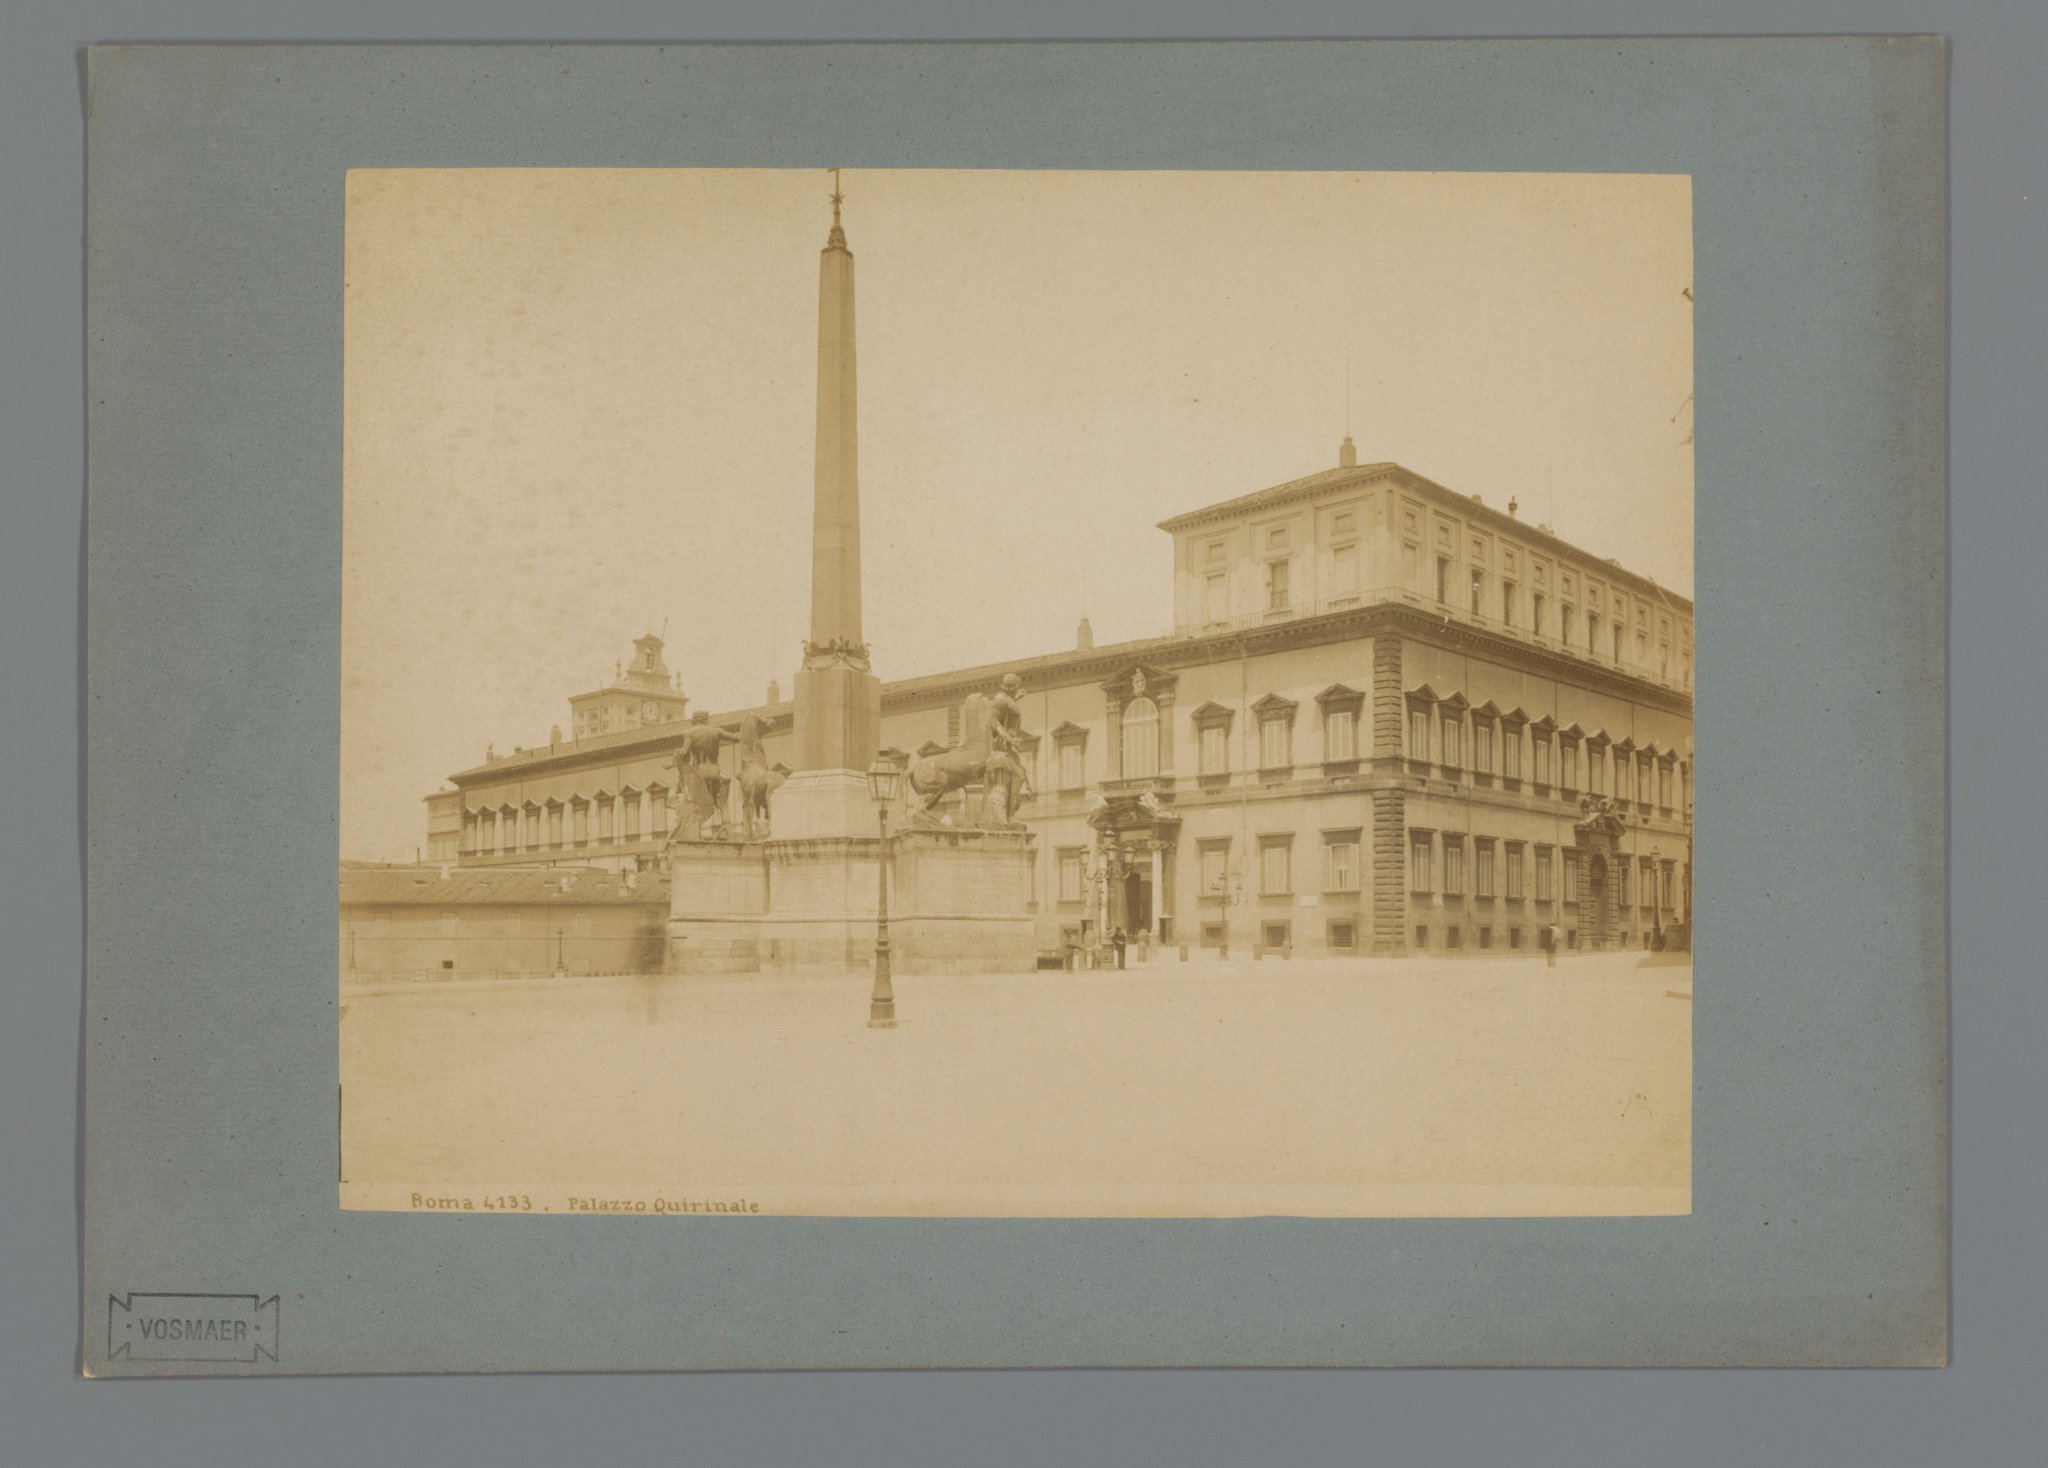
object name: photograph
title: Palazzo Quirinale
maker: Anonymous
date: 1851-1900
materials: cardboard, paper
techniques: albumen print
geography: rome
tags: palace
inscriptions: collector's mark: ‘VOSMAER’, number: ‘4133.’